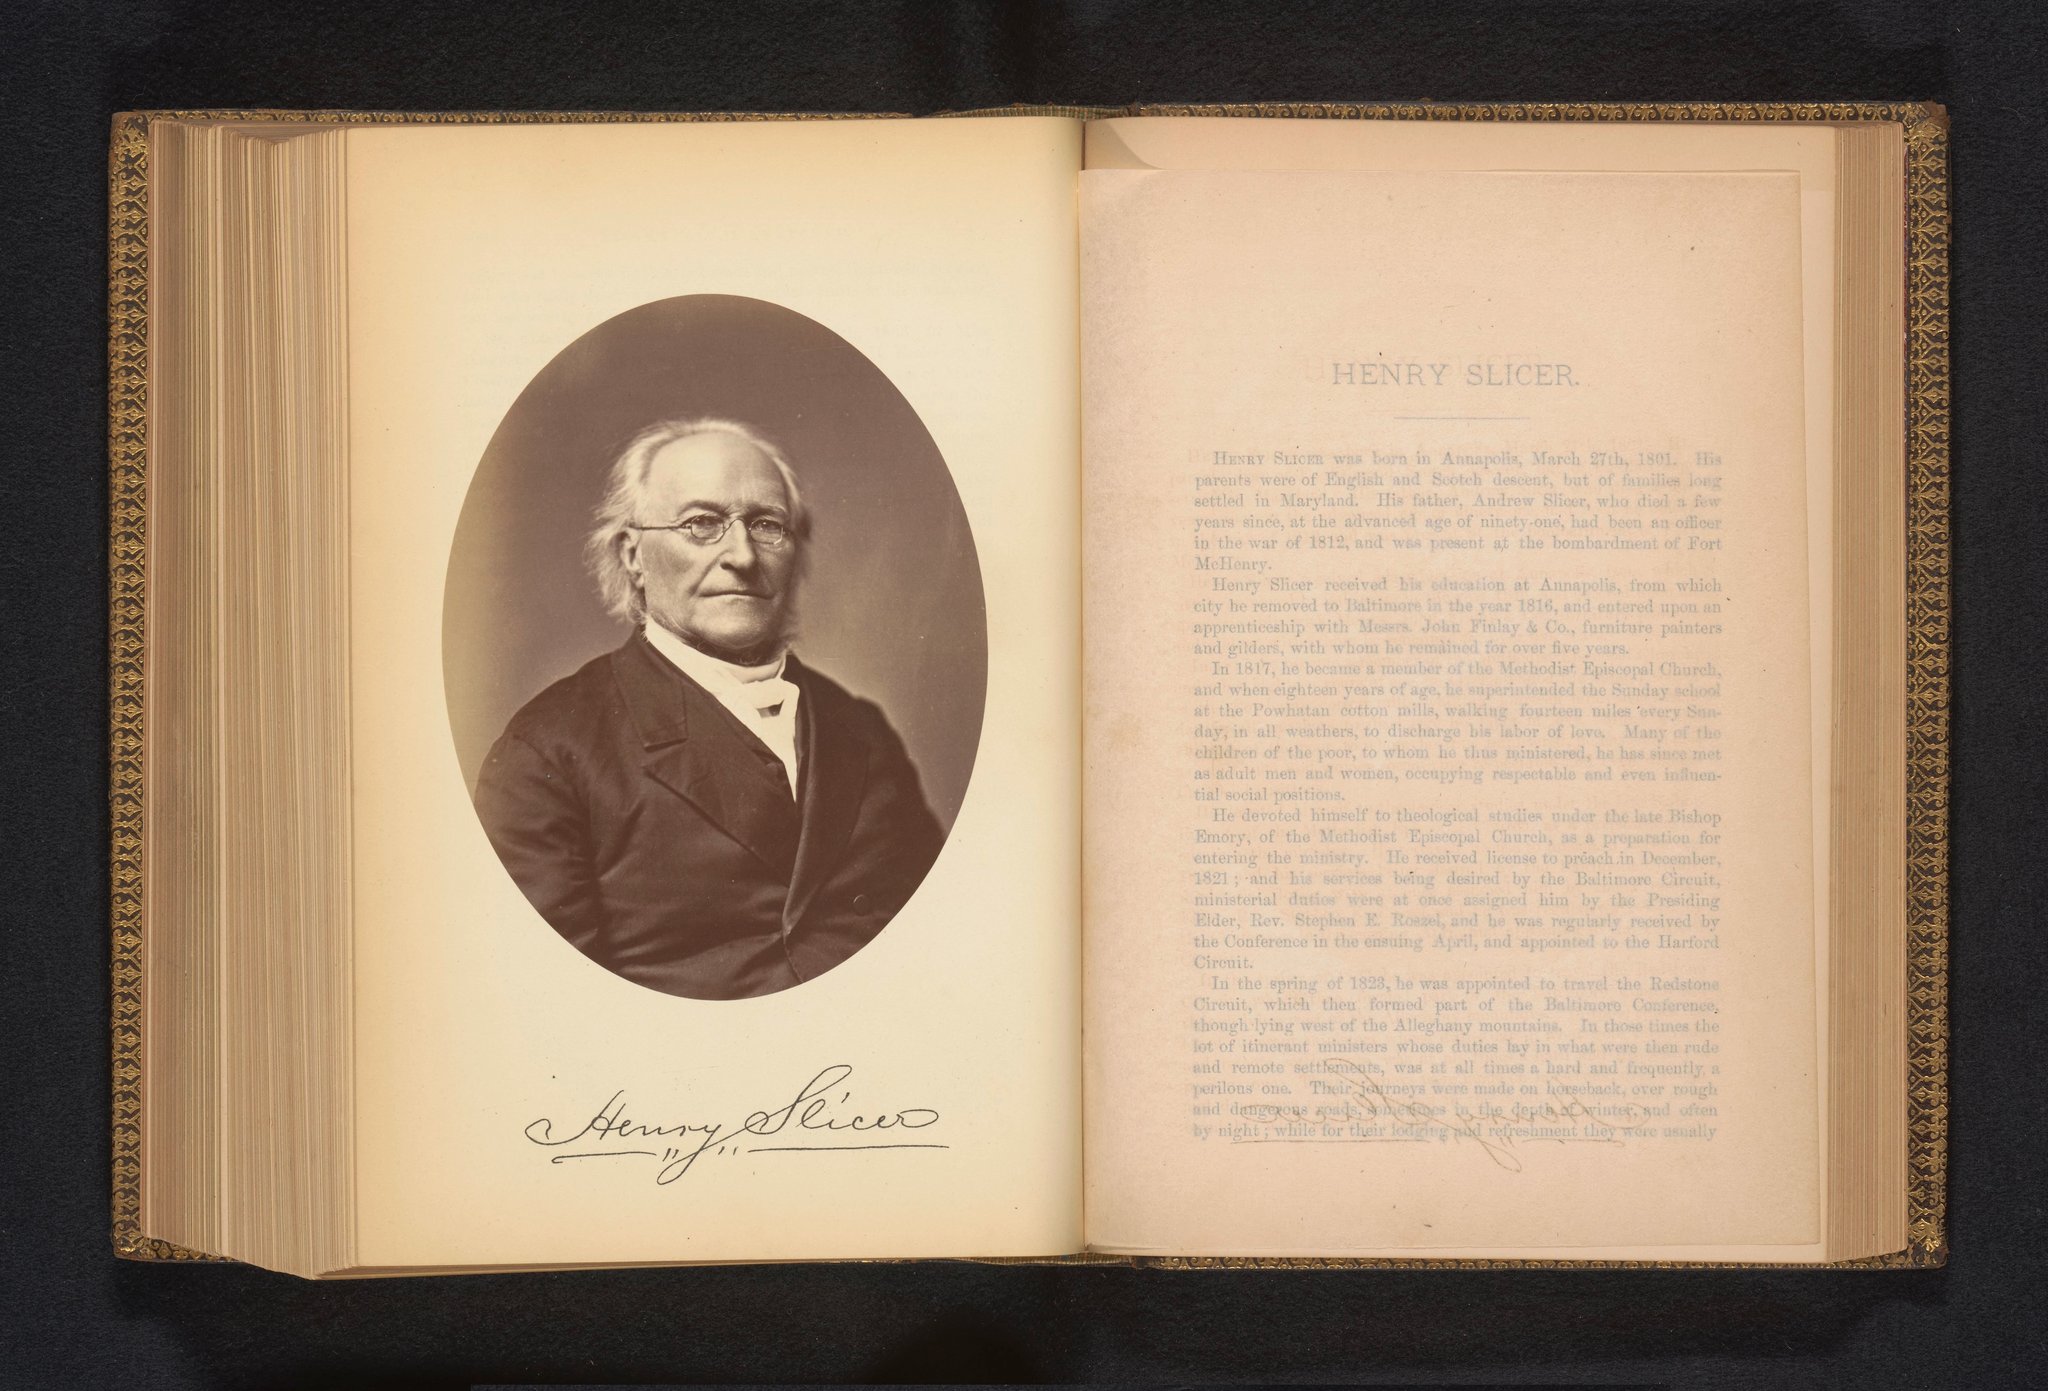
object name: page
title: Portret van Henry Slicer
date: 1866-1871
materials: photographic support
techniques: albumen print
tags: historical persons